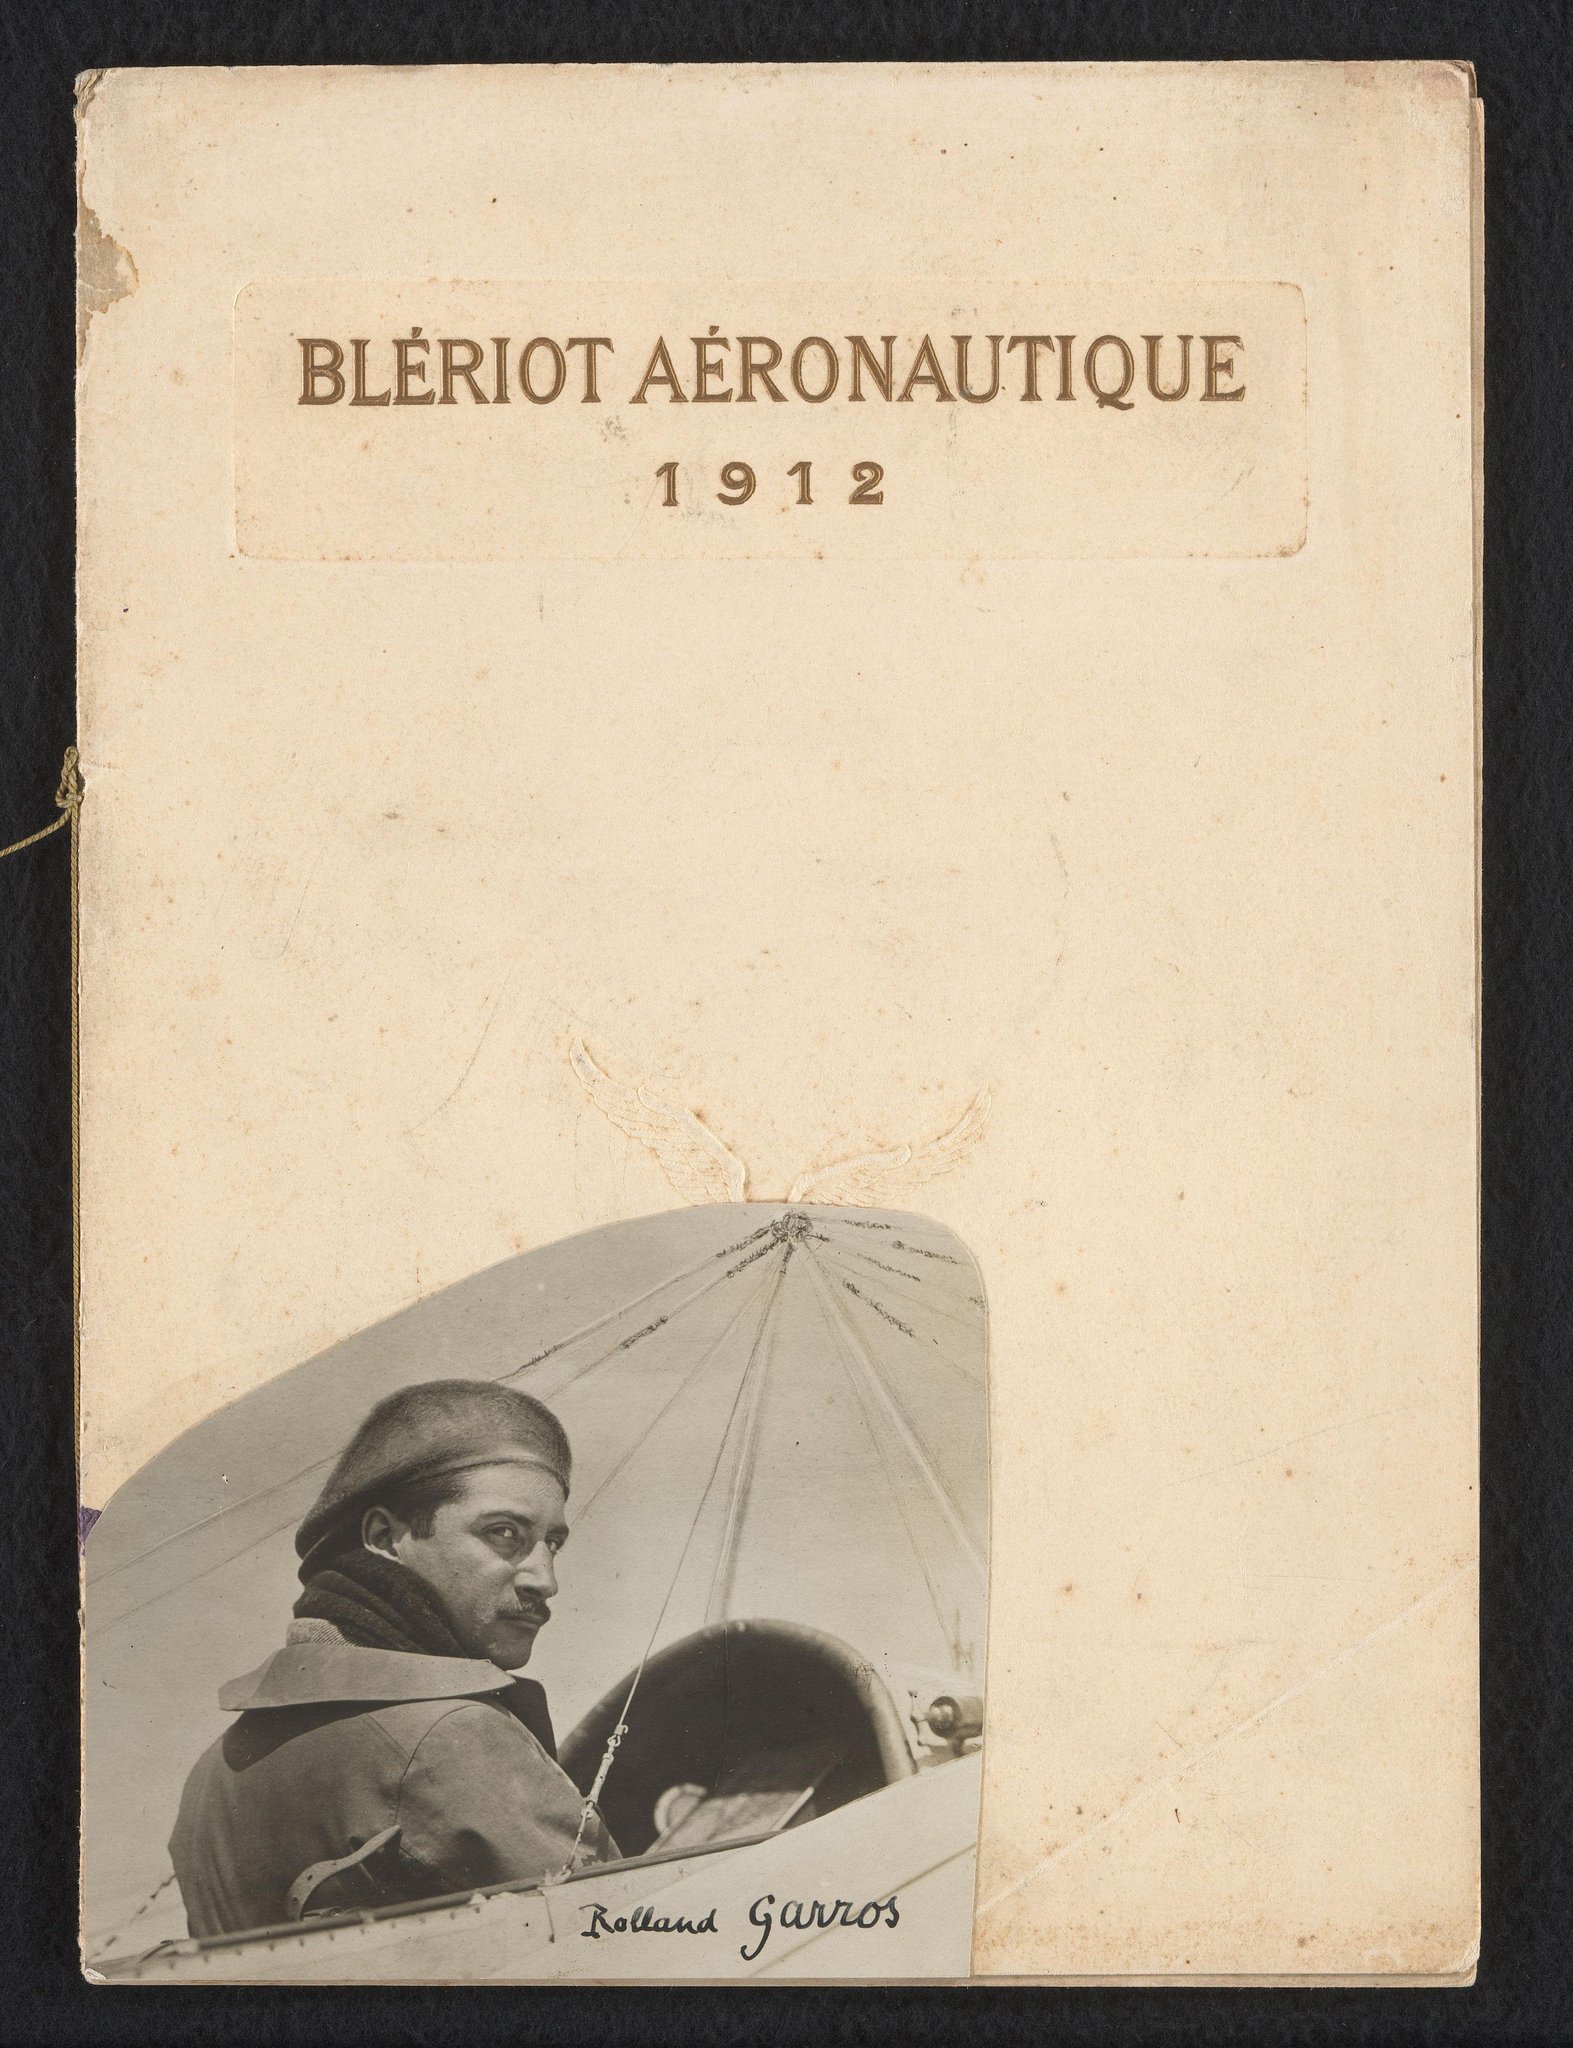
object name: photograph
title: Portret van Roland Garros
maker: Anonymous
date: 1907-1912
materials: paper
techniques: gelatin silver print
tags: aircraft, aeroplane, pilot, historical persons